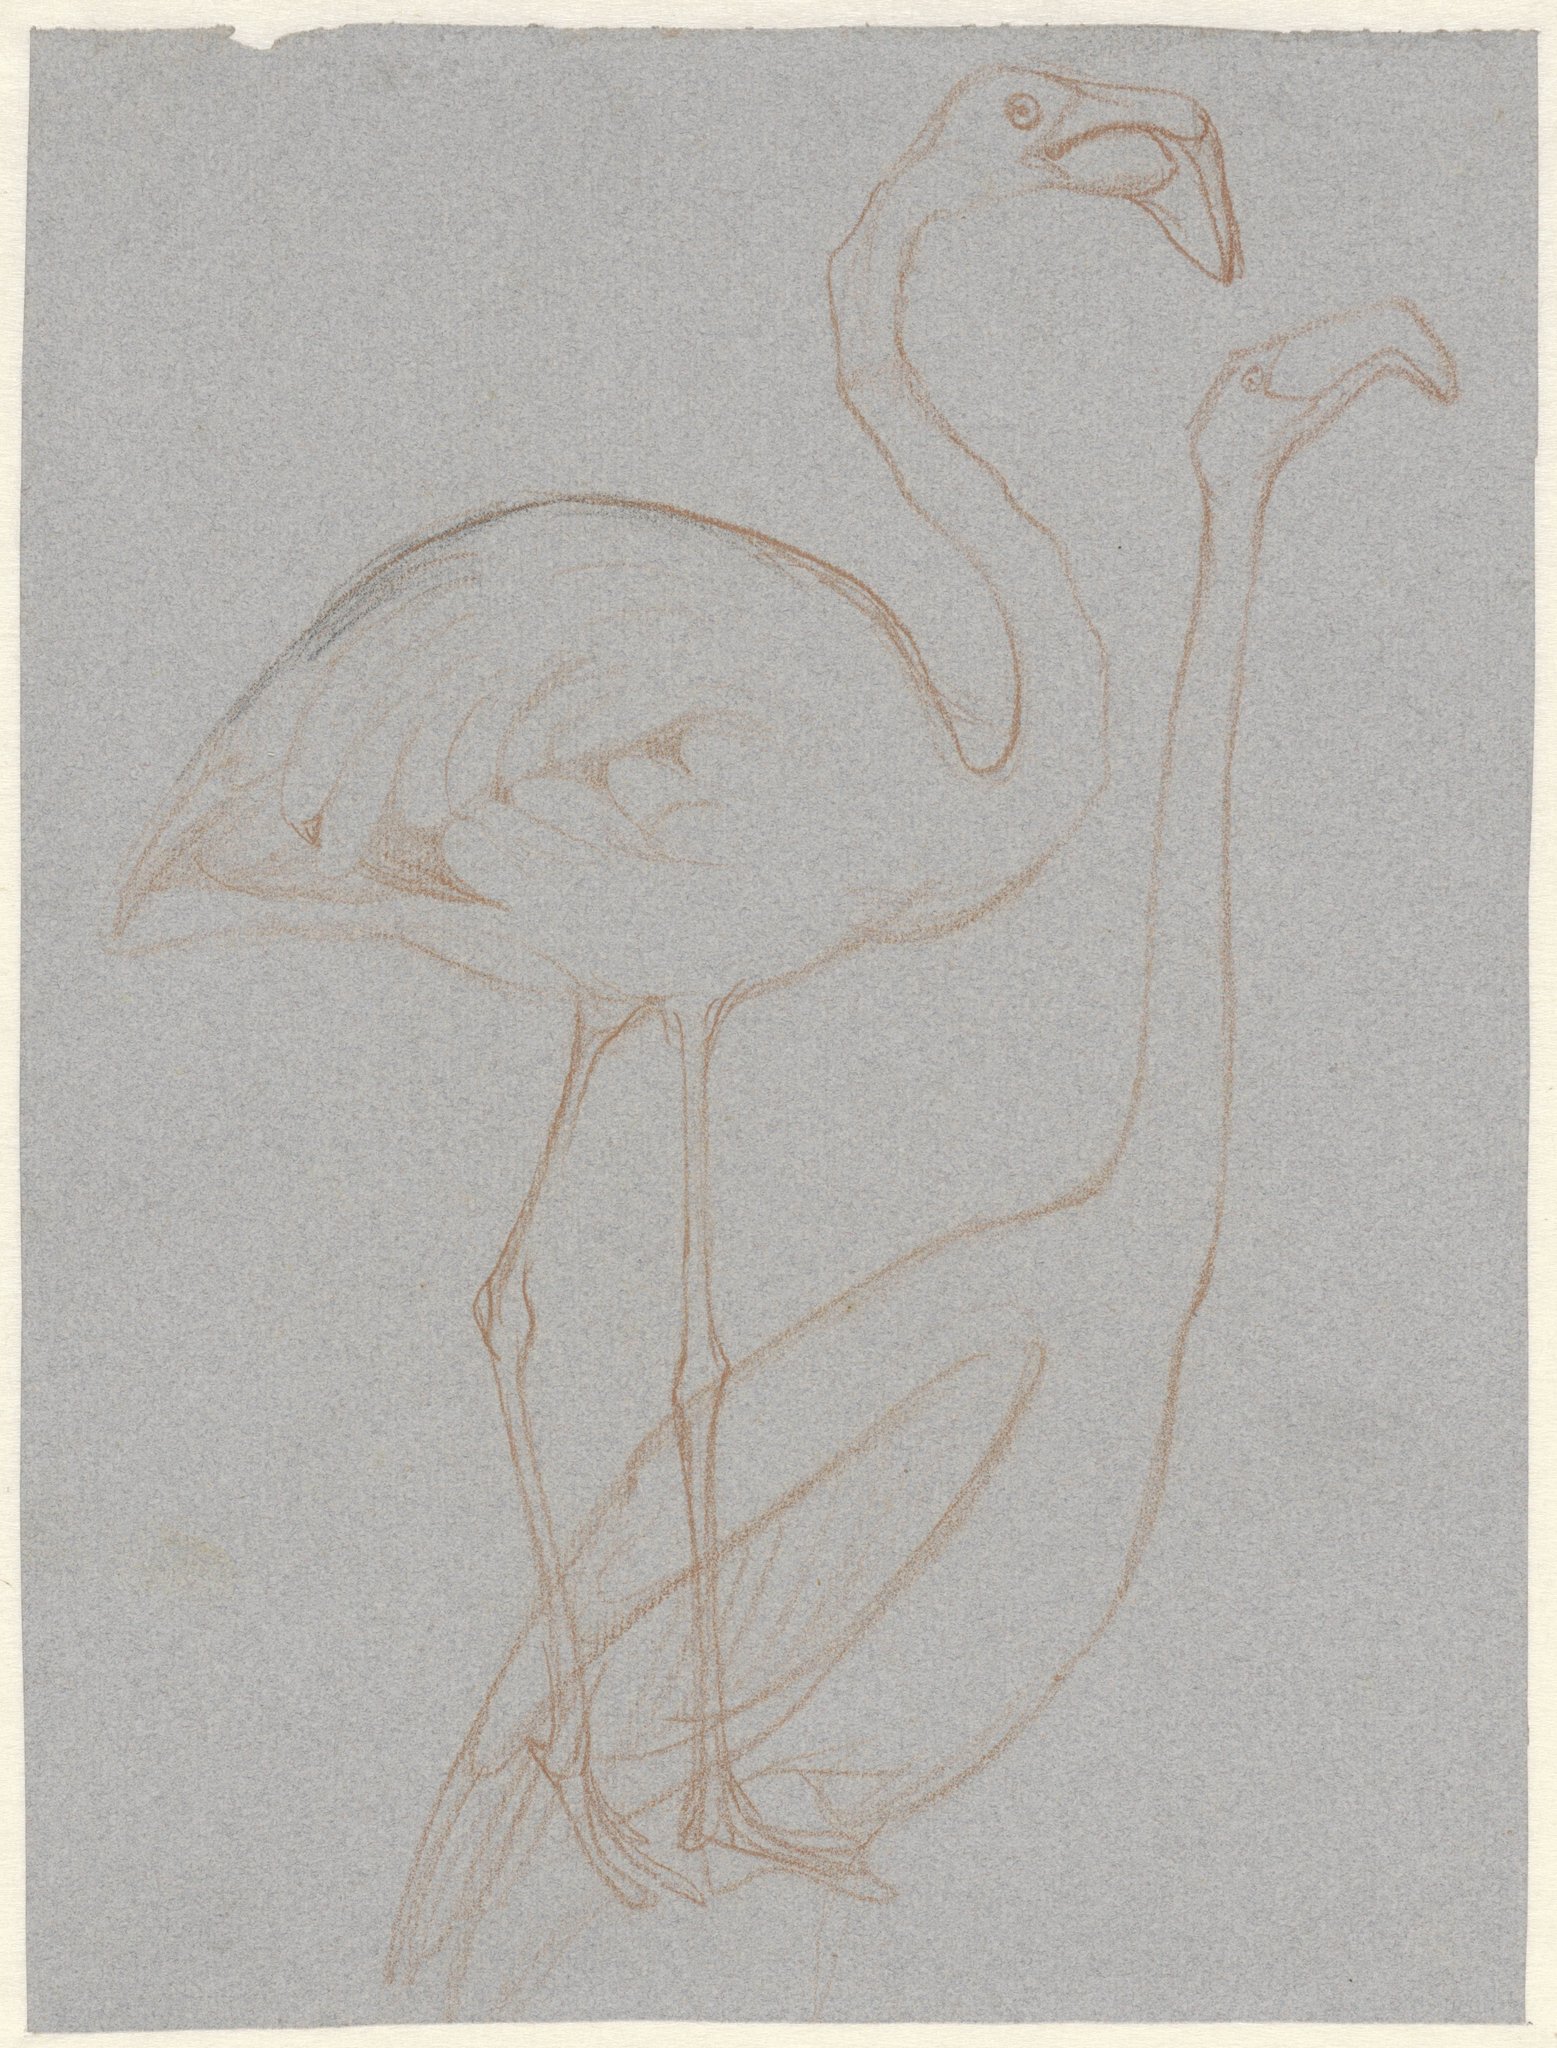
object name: drawing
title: Twee studies van een flamingo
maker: theo van hoytema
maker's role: draughtsman, painter, print maker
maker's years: 1863-1917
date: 1873-1917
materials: chalk, paper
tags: shore-birds and wading-birds: flamingo